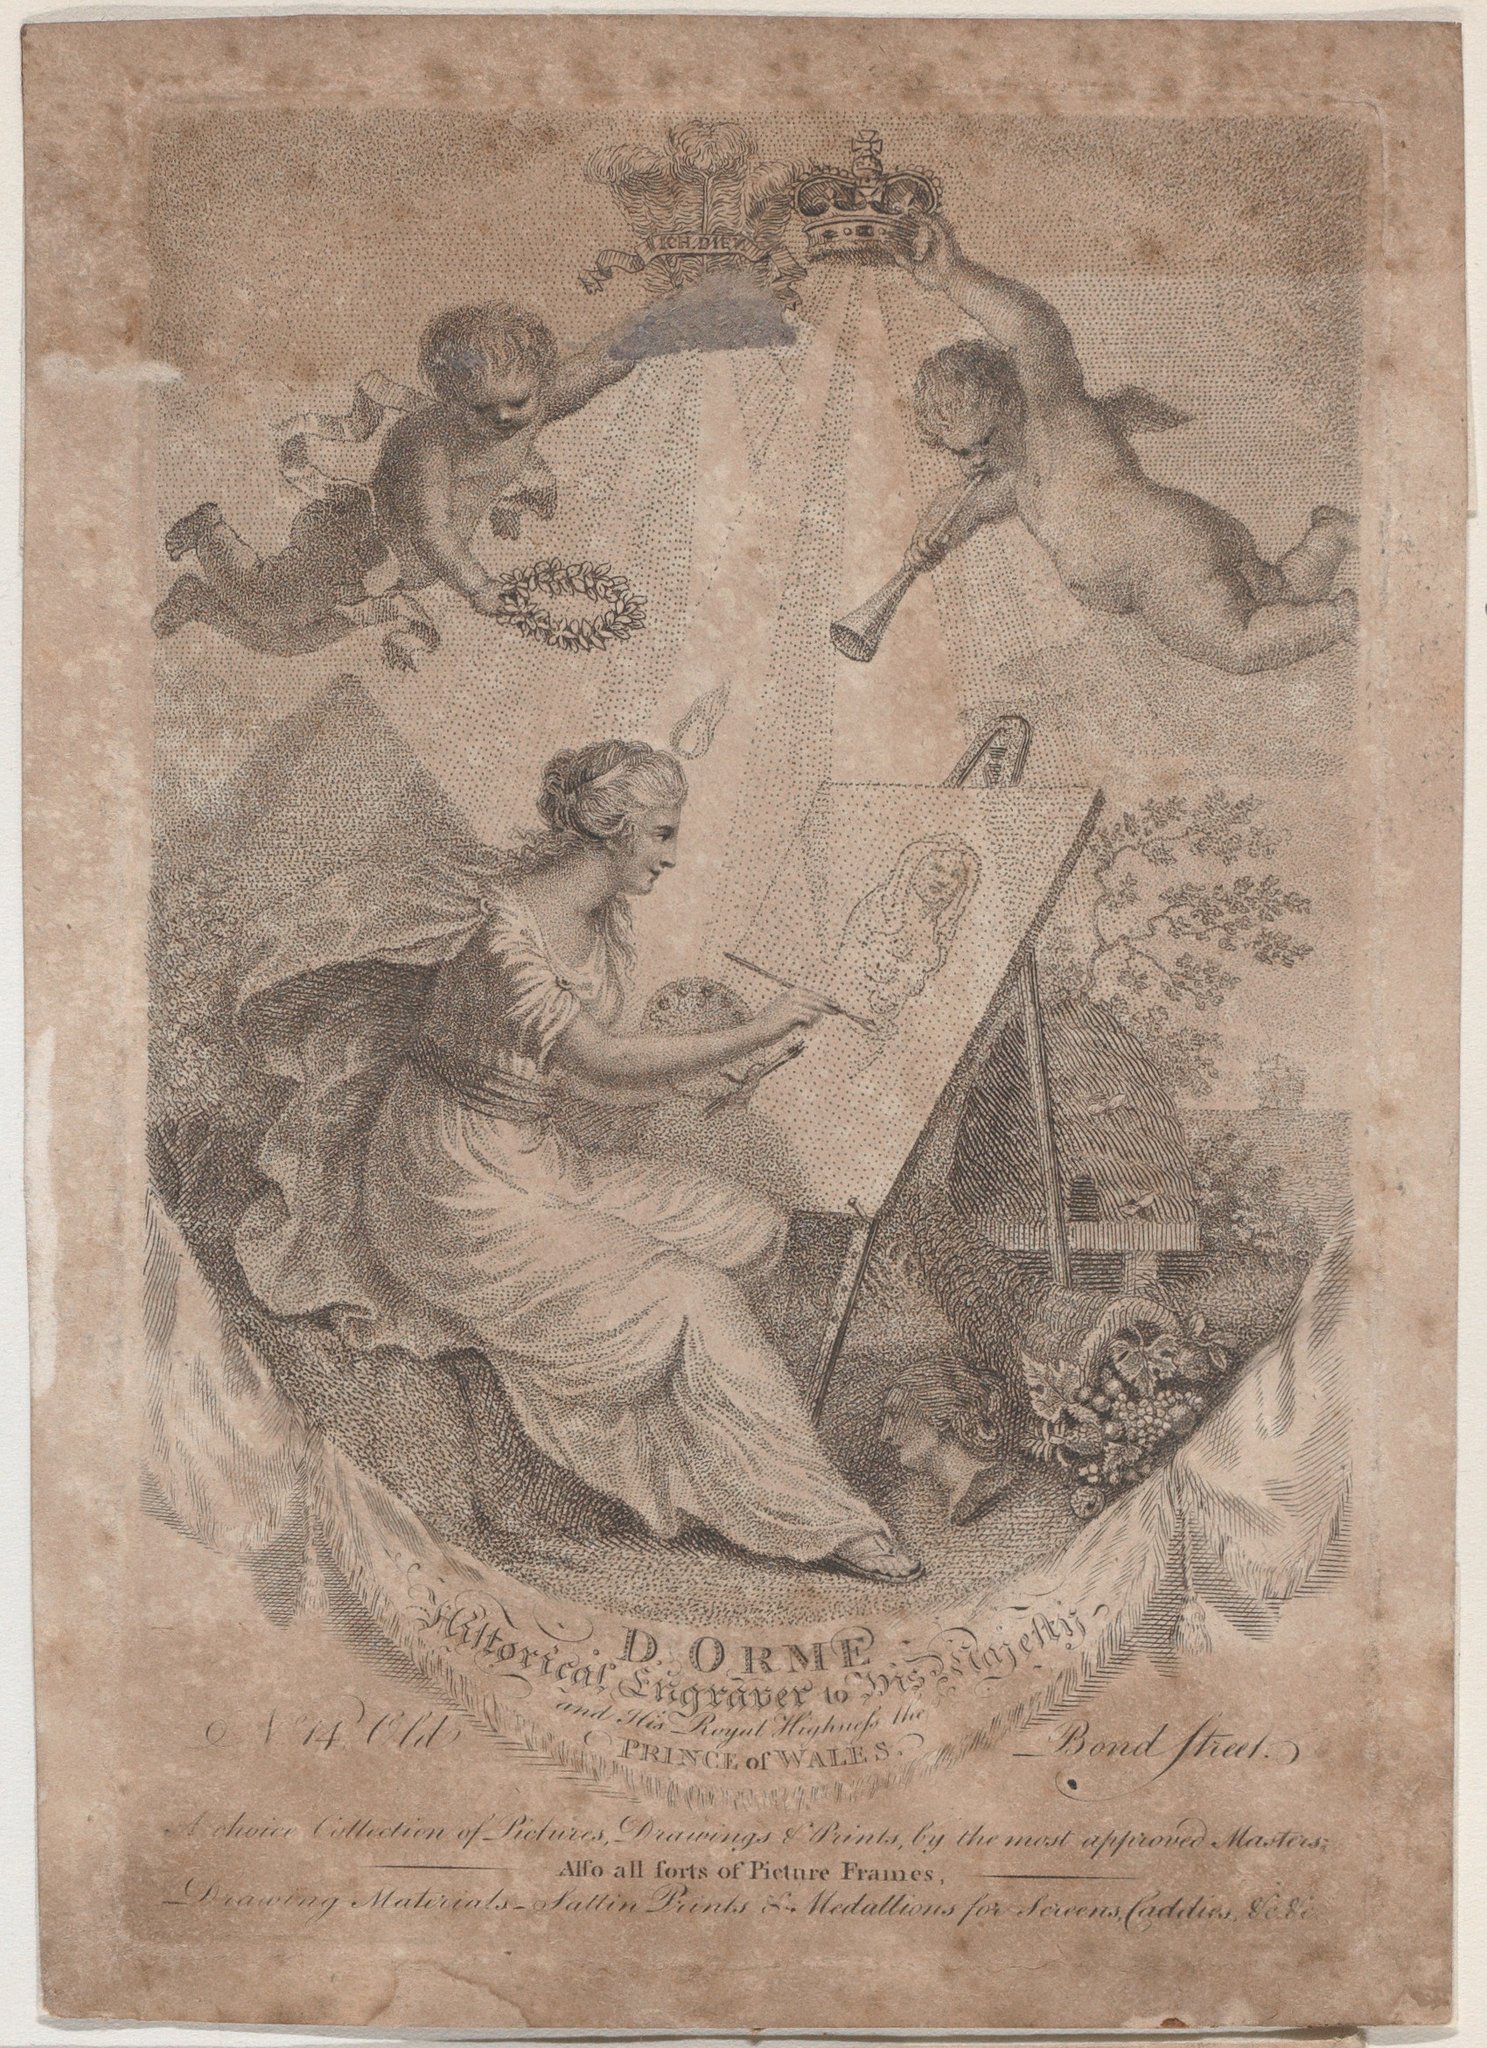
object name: print, trade card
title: Trade Card for Dorme, Engraver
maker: anonymous, british, 19th century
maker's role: artist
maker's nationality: british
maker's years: 1800-1900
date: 1801-1900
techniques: engraving